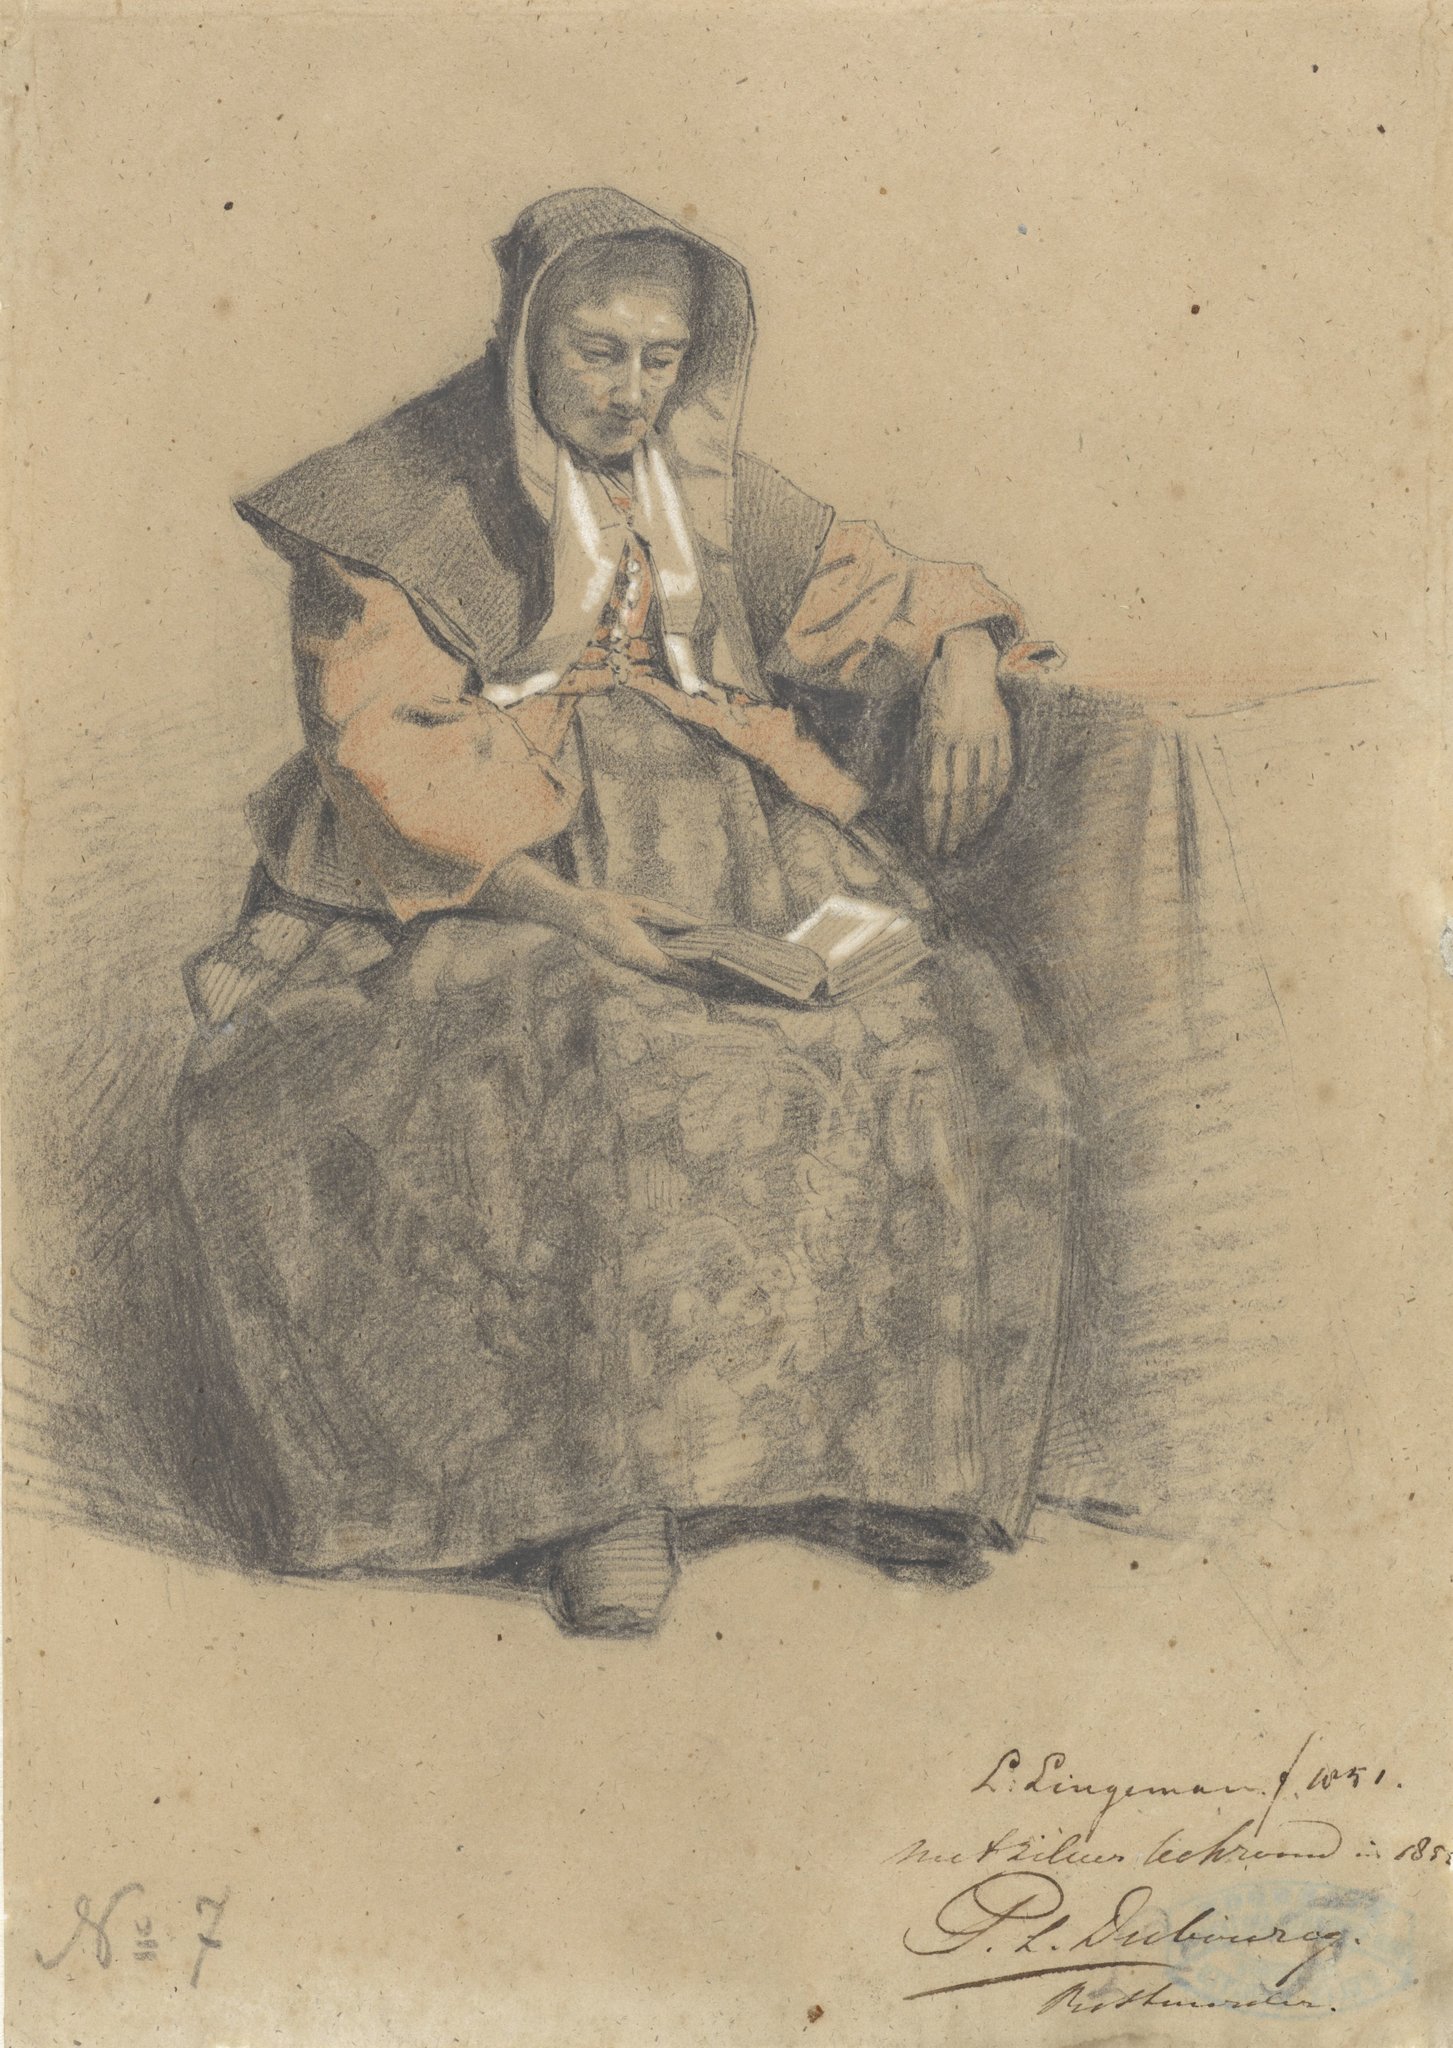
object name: drawing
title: Zittende vrouw met boek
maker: lambertus lingeman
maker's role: draughtsman, painter, print maker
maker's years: 1829-1894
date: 1851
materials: chalk, paper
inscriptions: date: ‘23 Maart 1851’, date: ‘1851’